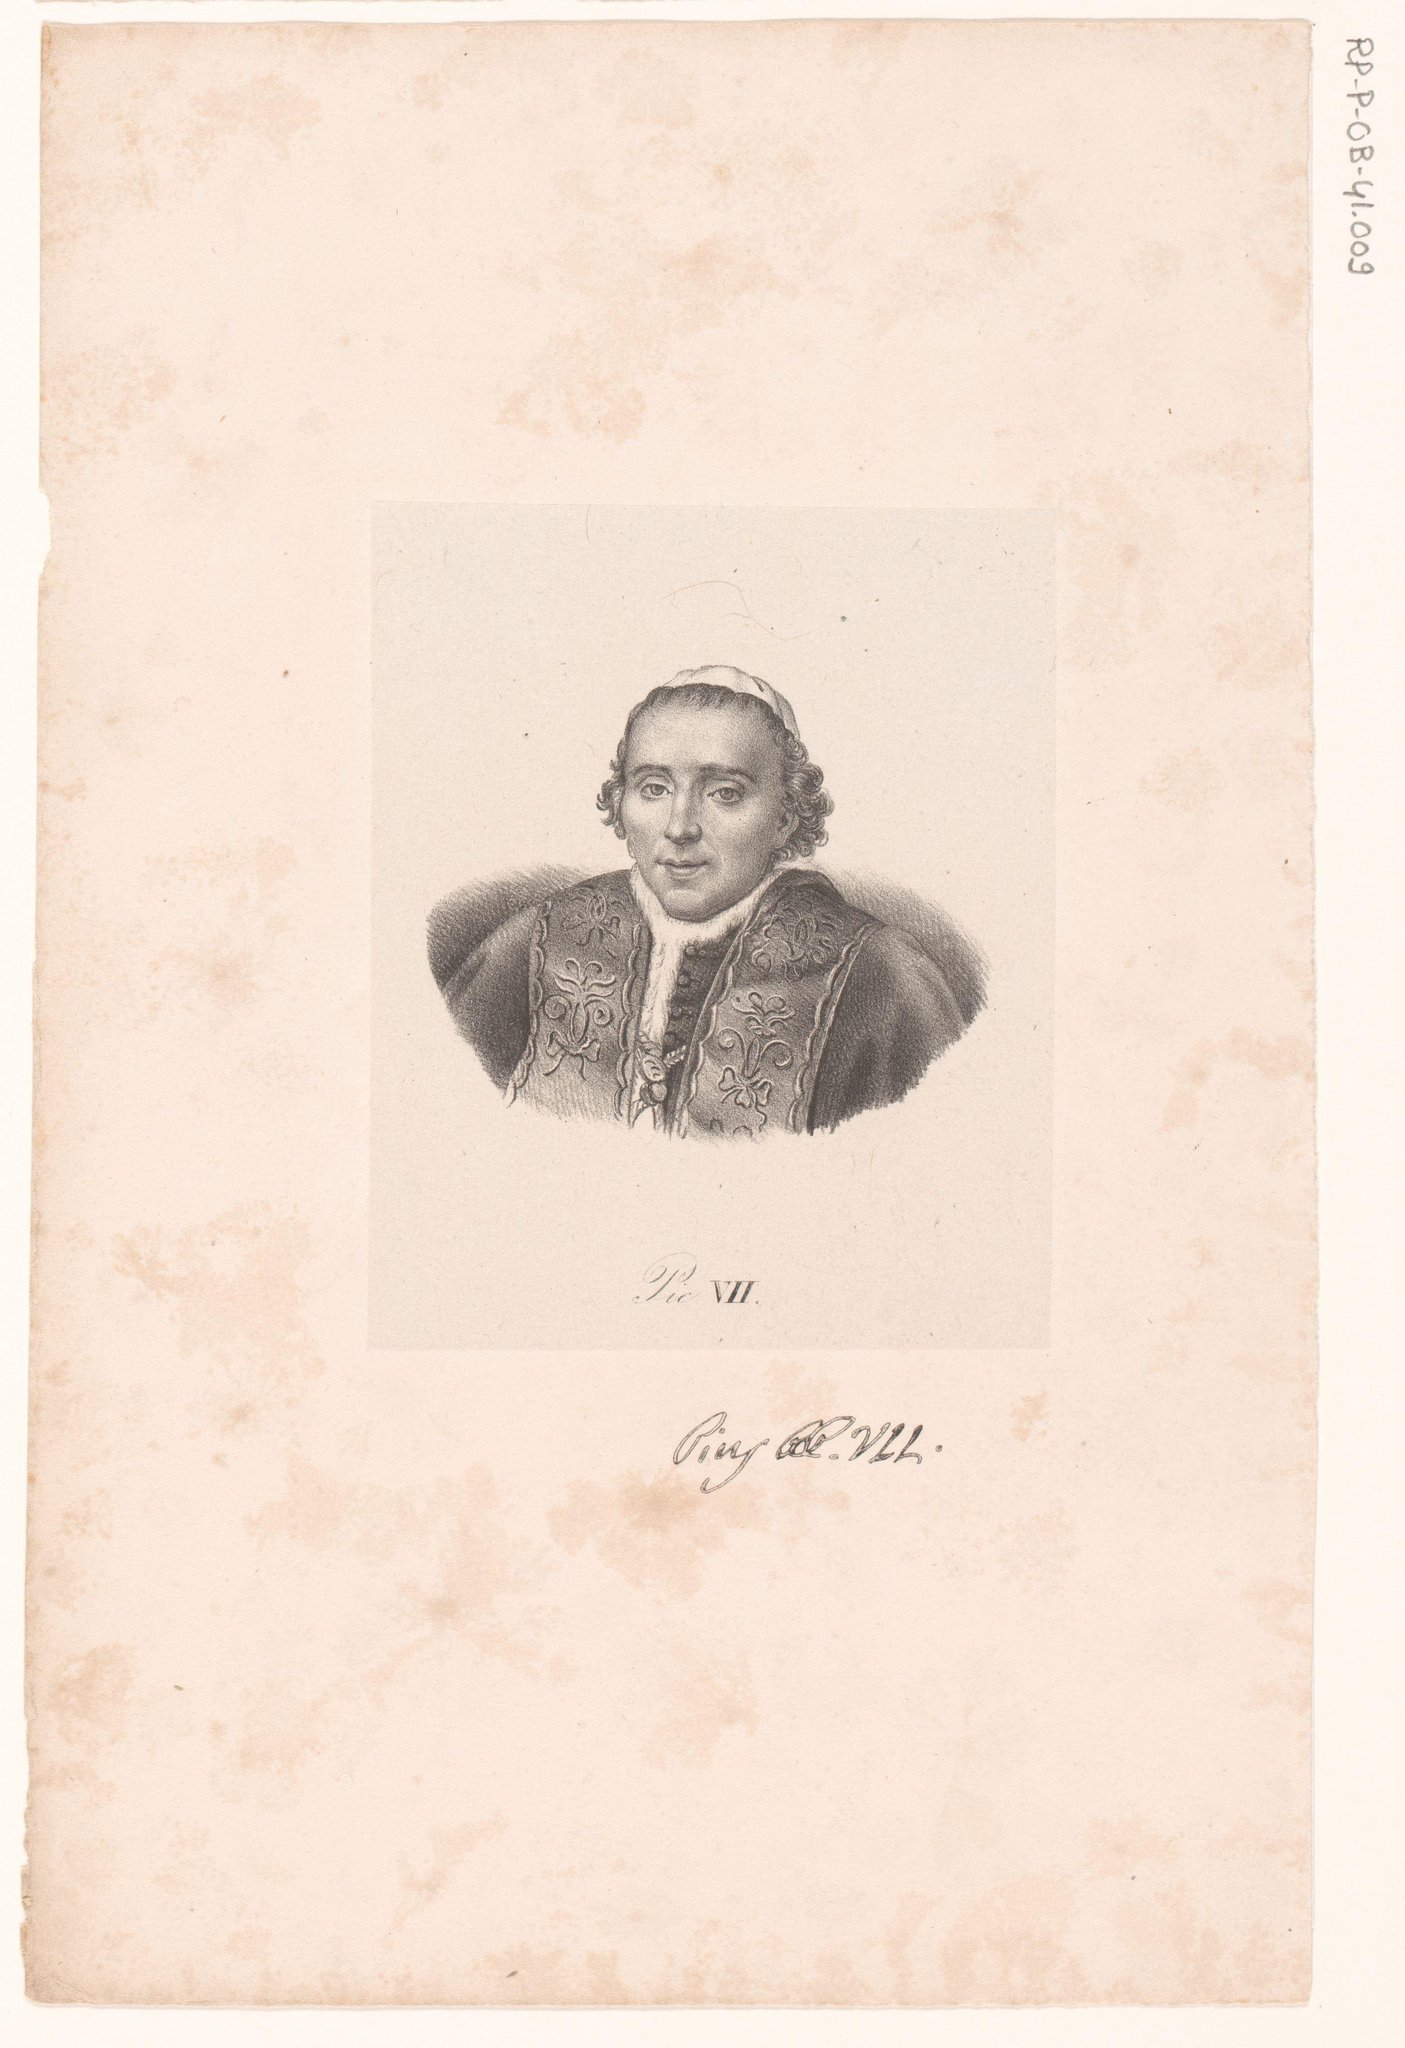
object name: print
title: Pie VII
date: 1818-1842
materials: paper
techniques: lithograph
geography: paris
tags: rome, pius vii, historical persons